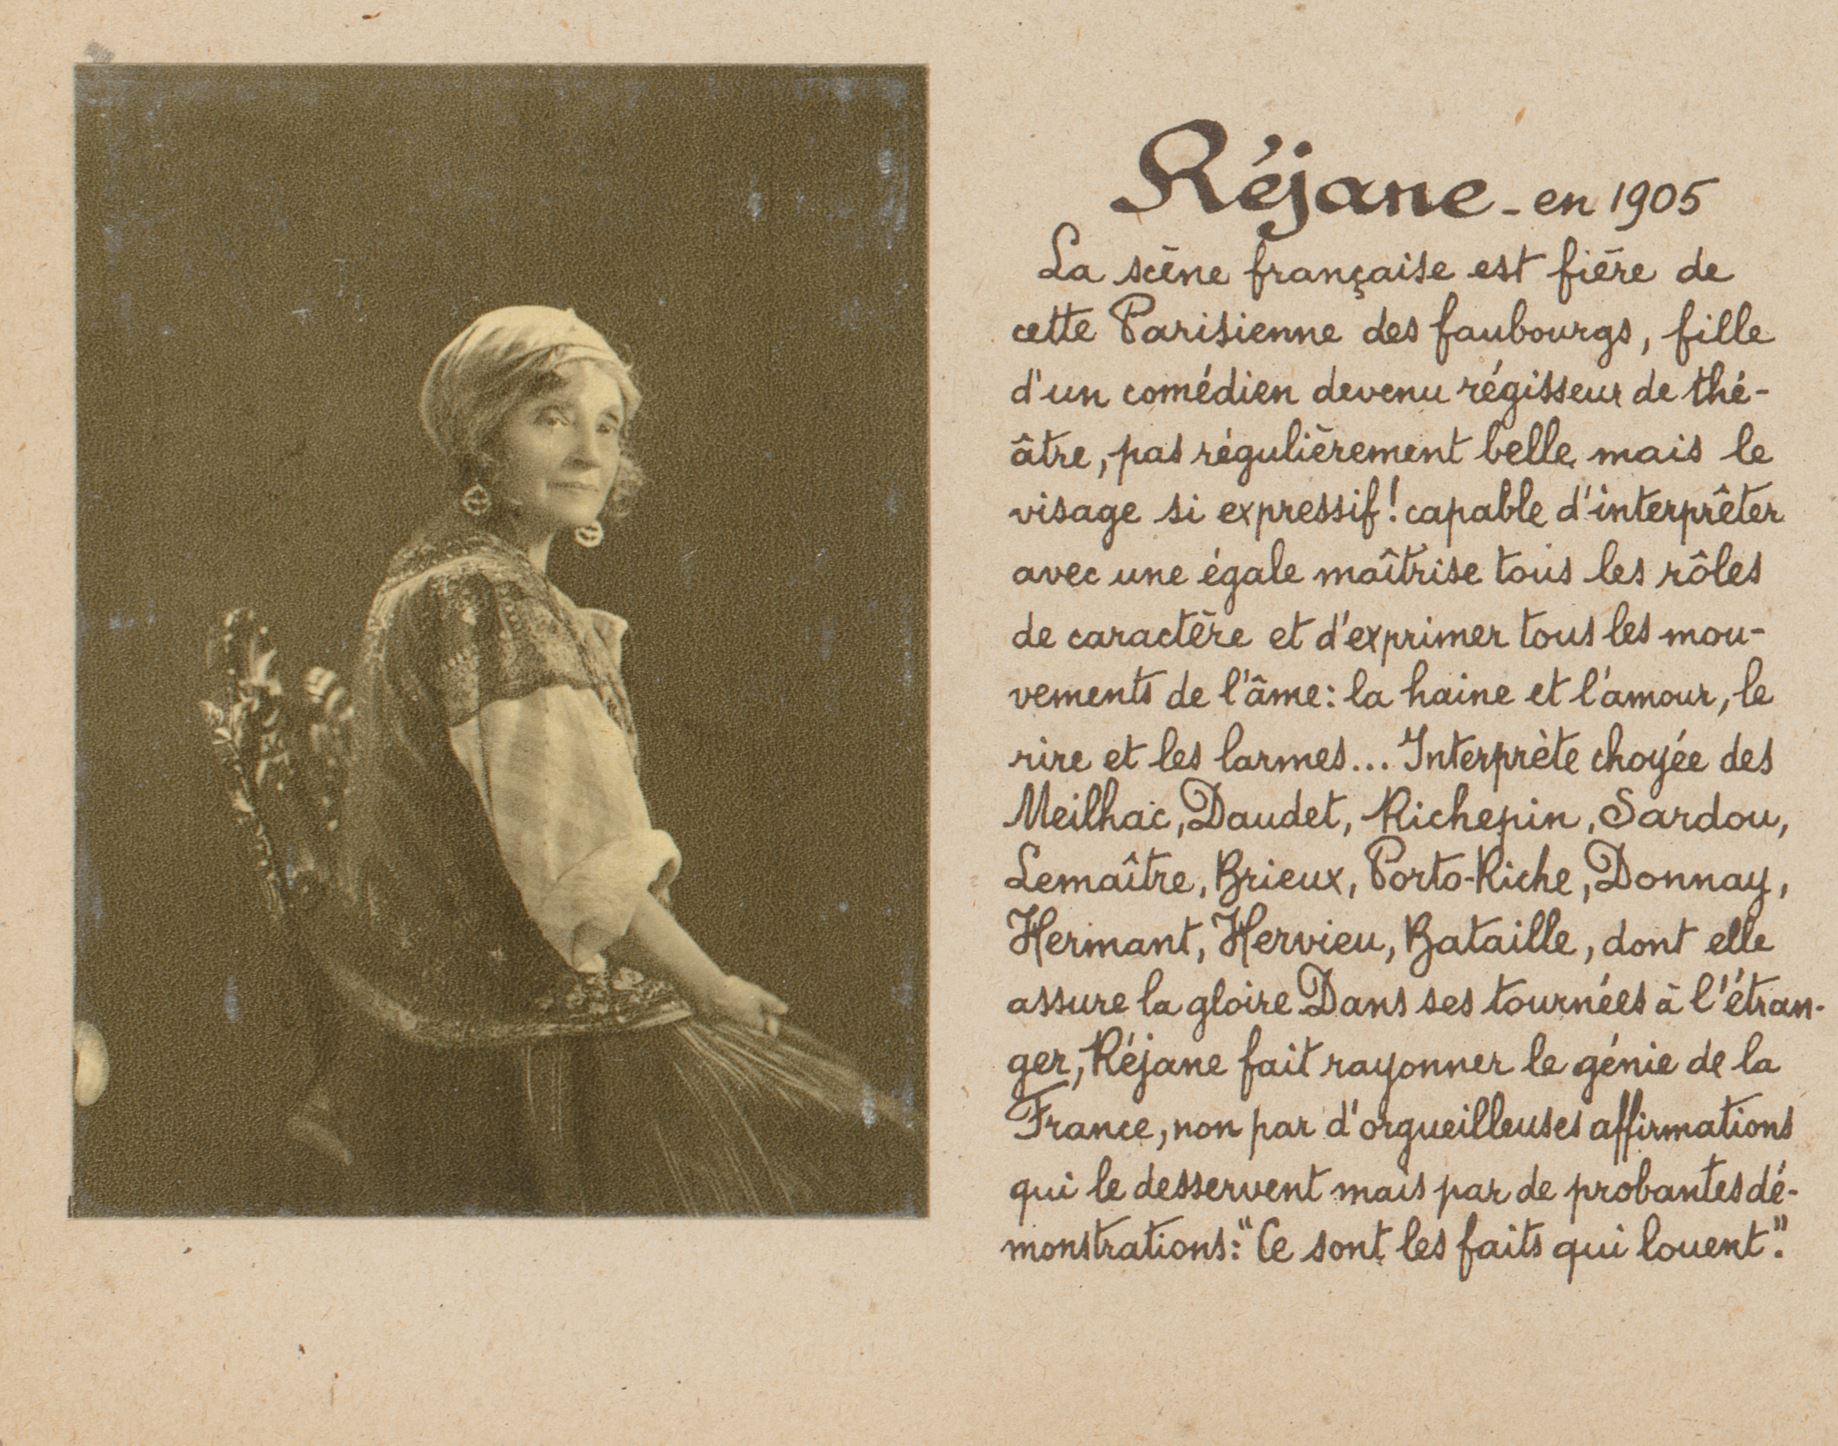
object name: photograph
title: Réjane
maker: Anonymous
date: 1905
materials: paper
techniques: rotogravure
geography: france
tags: paris, portrait of actor, actress, france